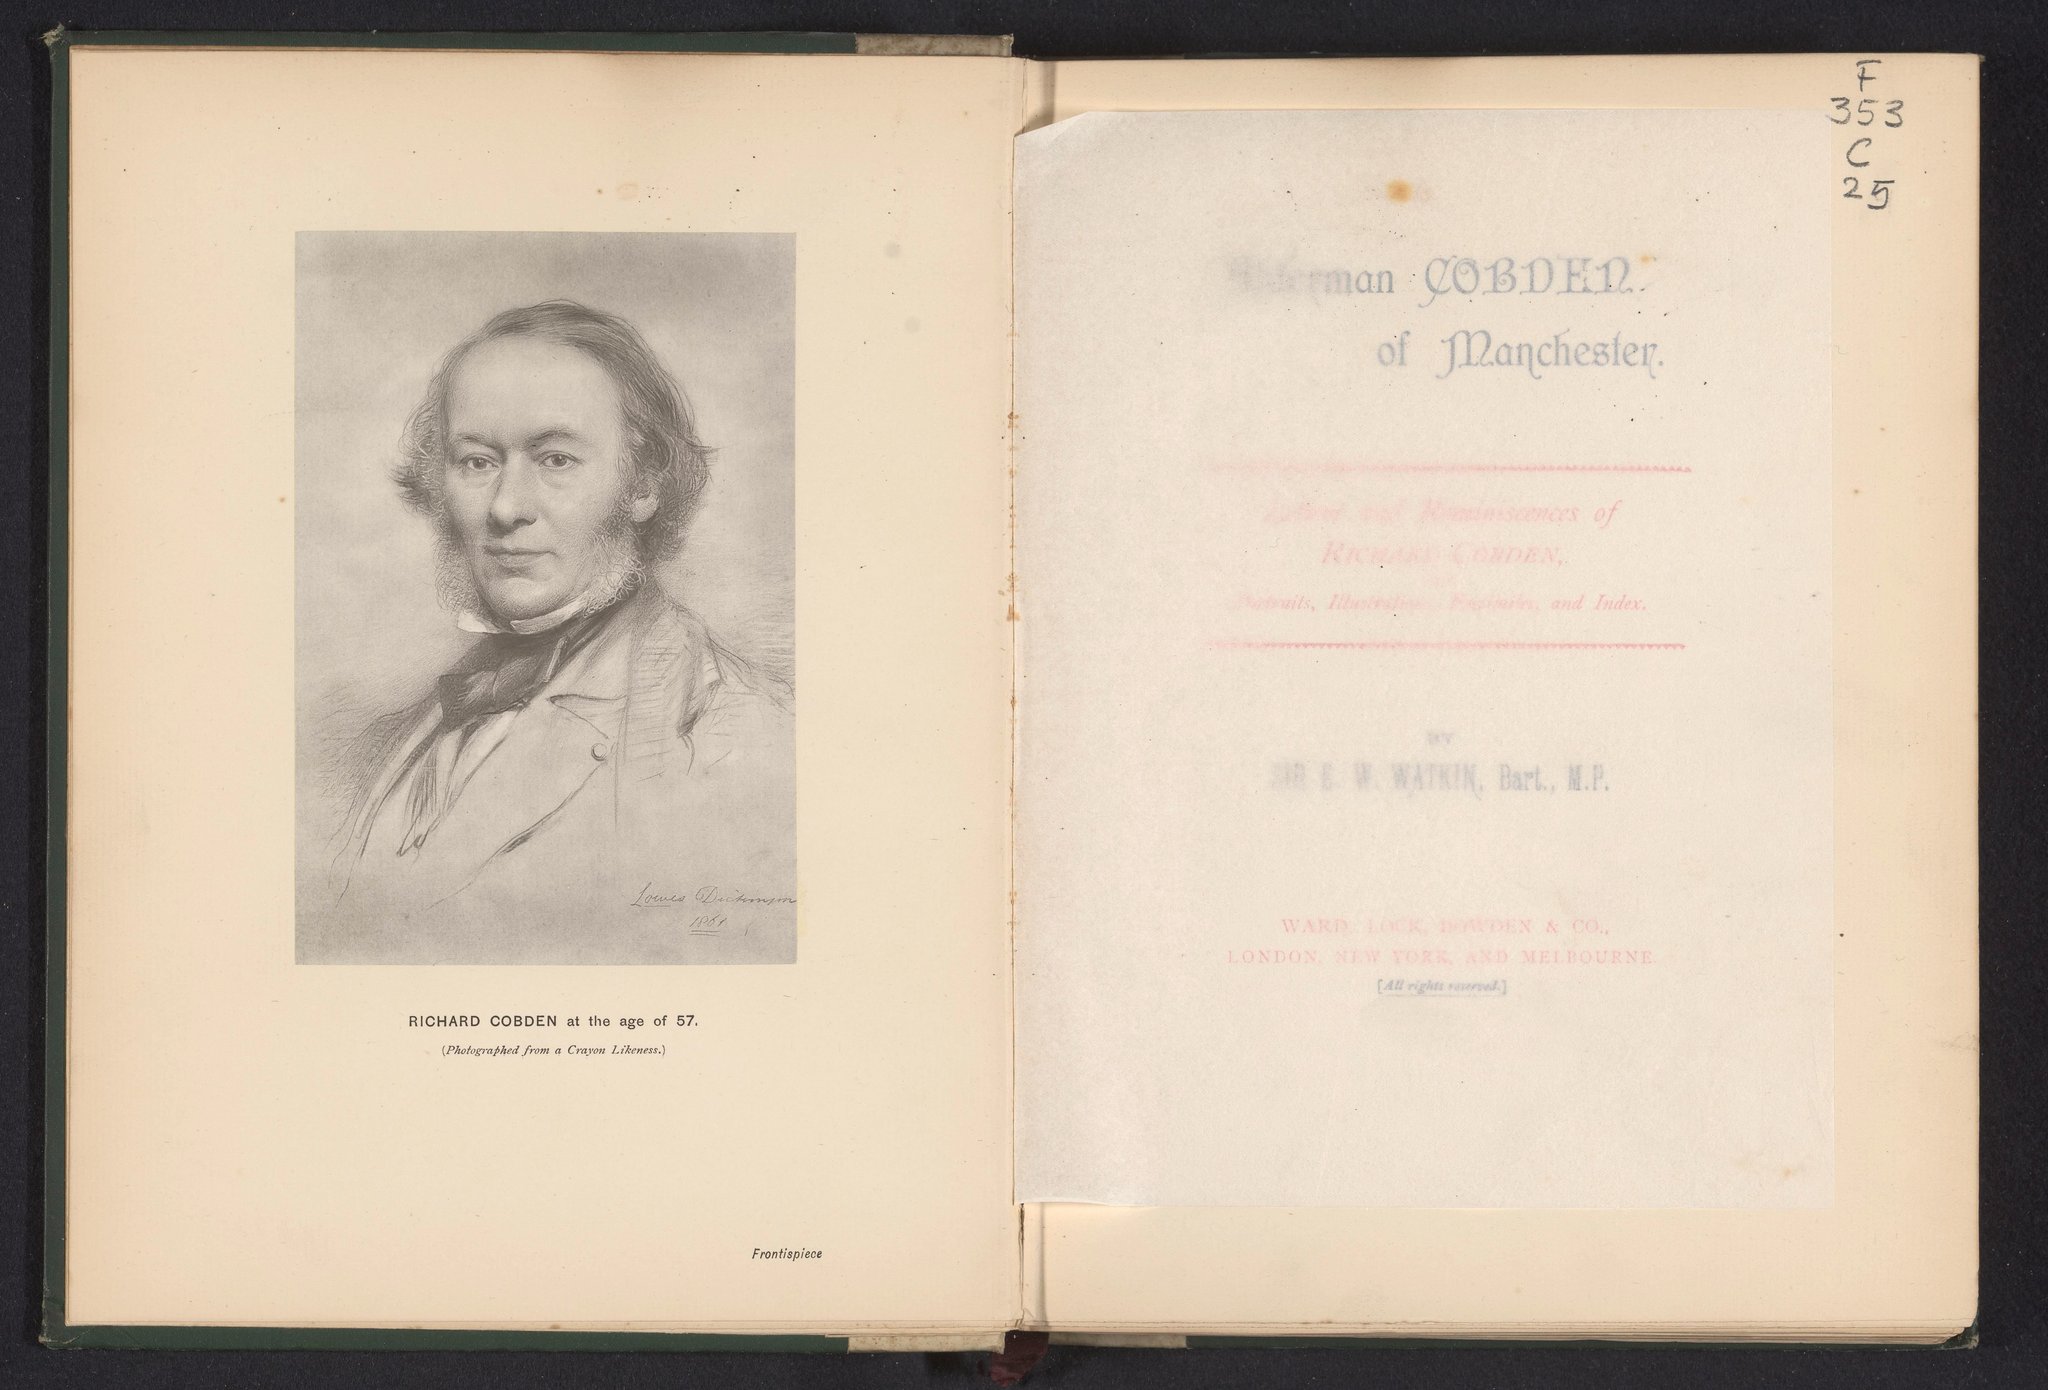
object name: photomechanical print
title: Fotoreproductie van een portret van Richard Cobden door vermoedelijk Lowes Cato Dickinson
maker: Anonymous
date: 1881-1891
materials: paper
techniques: woodburytype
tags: politician, manufacturer, official; civil servant; functionary (in general)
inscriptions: name: ‘Lowes Dickinson 1861’